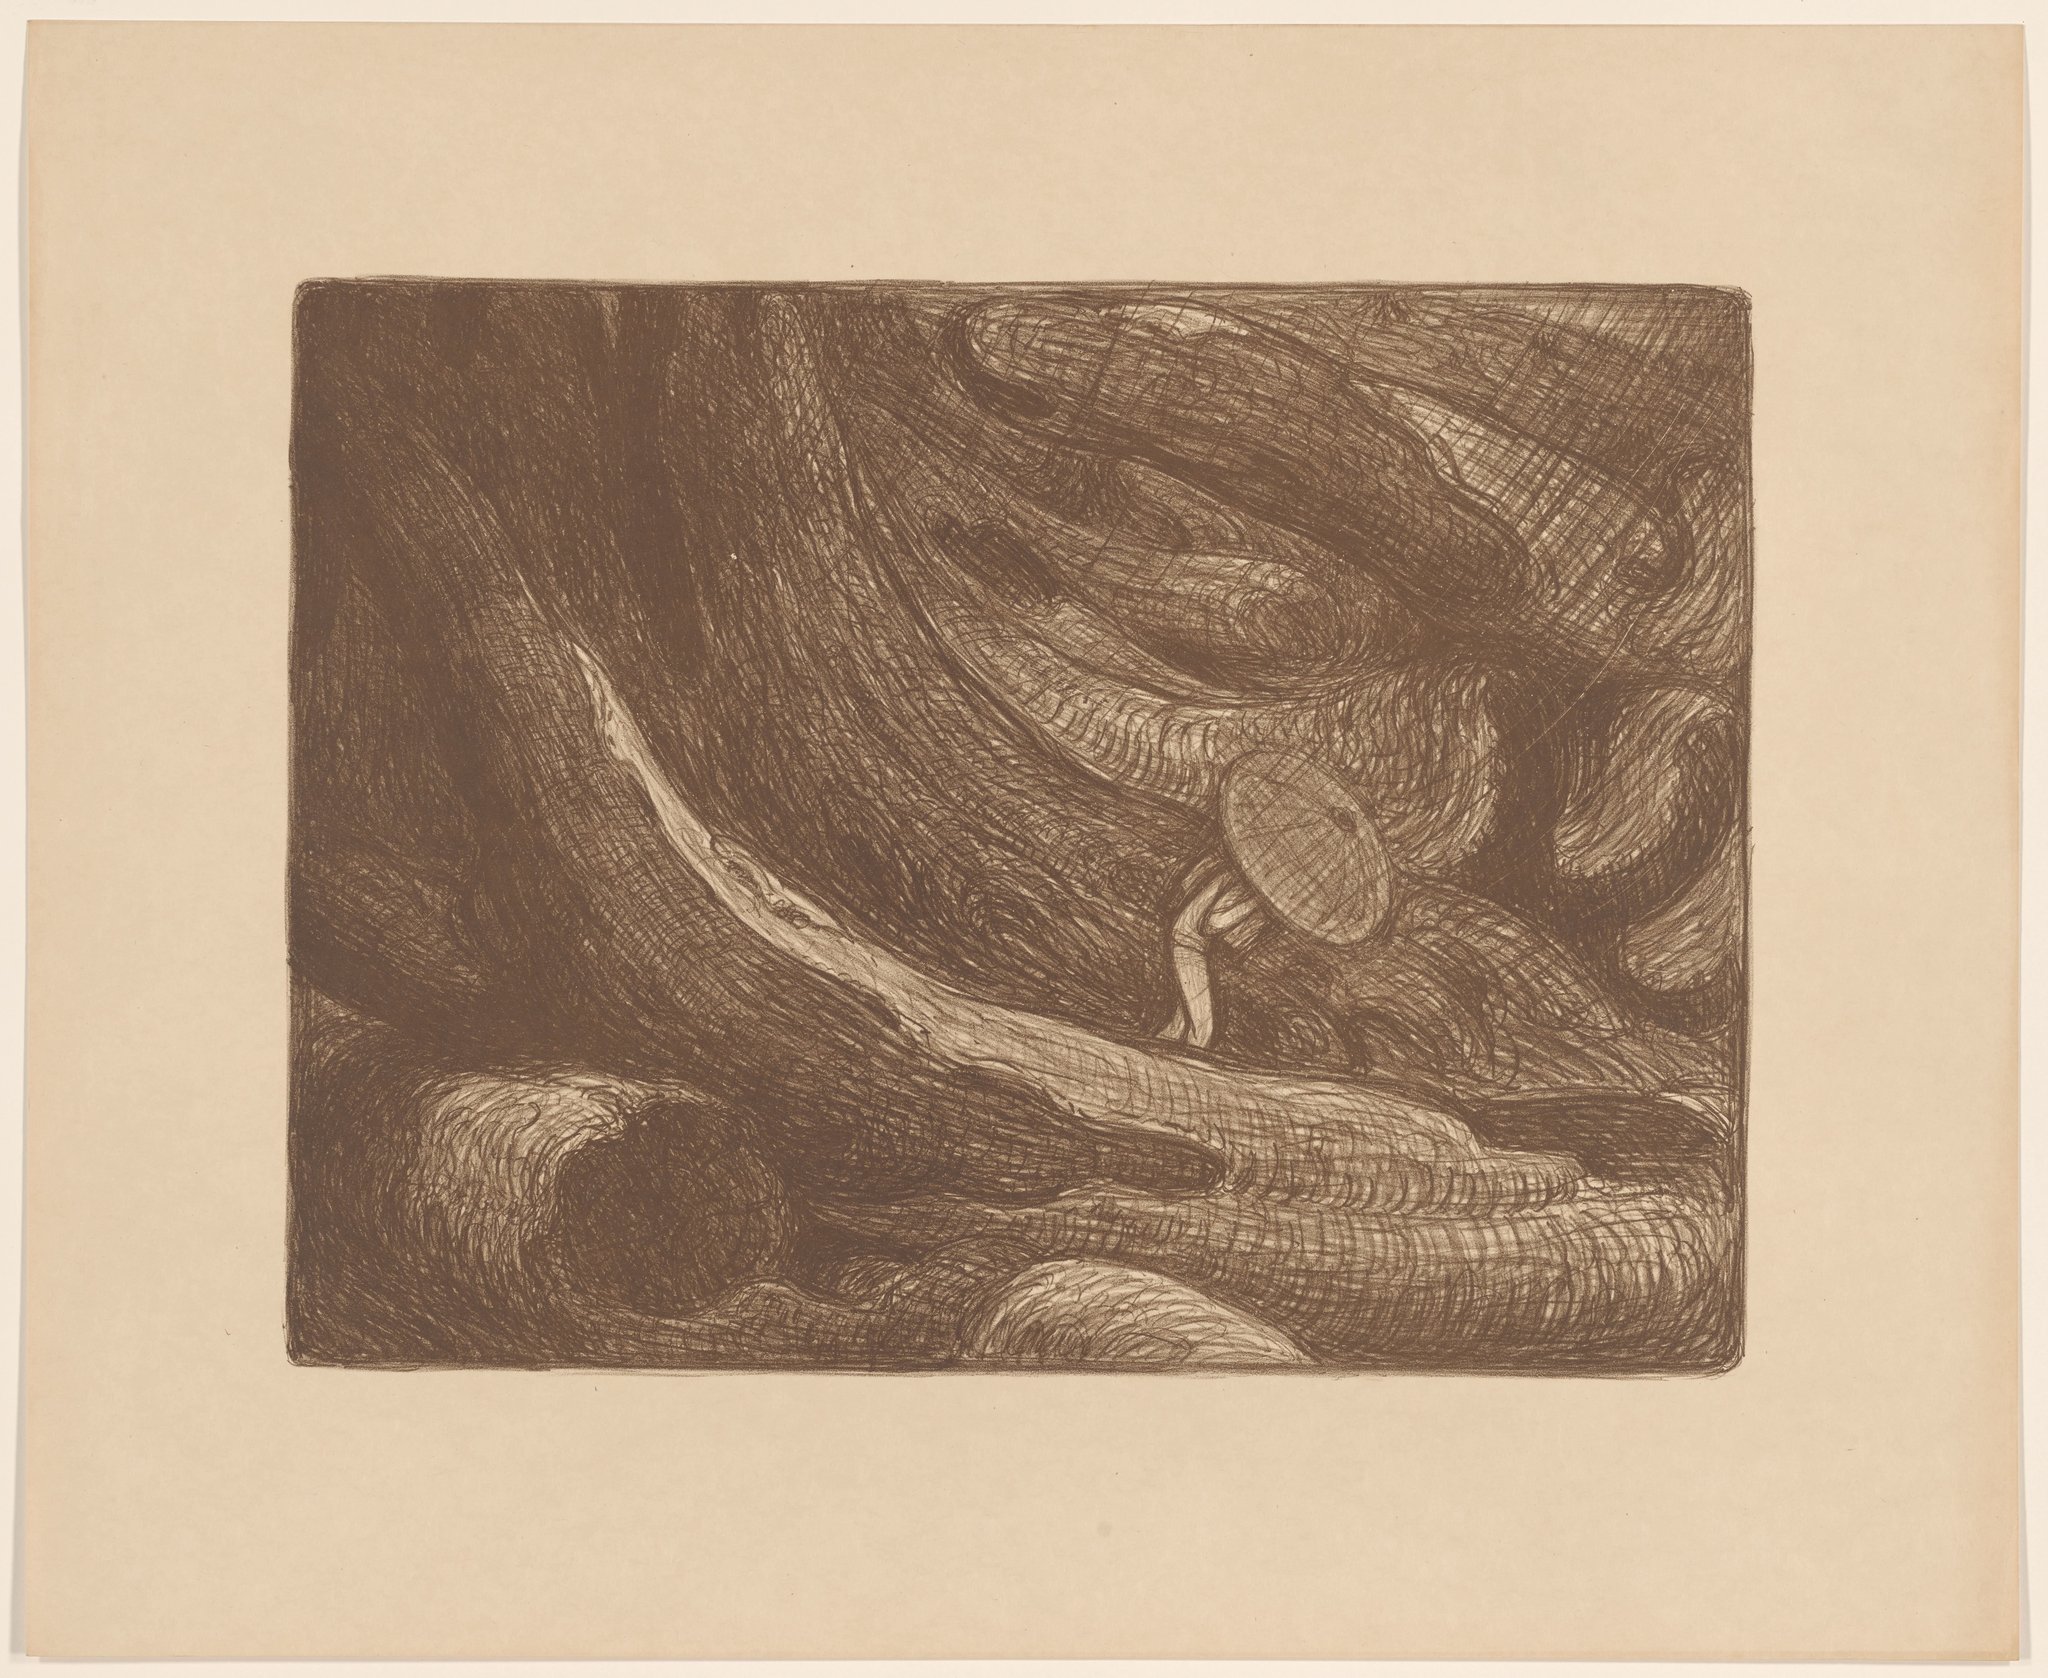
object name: print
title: Searching a cover, Java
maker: wijnand otto jan nieuwenkamp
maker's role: draughtsman, print maker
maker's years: 1874-1950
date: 1903-1918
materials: paper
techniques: lithograph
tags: downpour, rain shower, trees, umbrella, storm on land, java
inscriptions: collector's mark: Lugt 2228